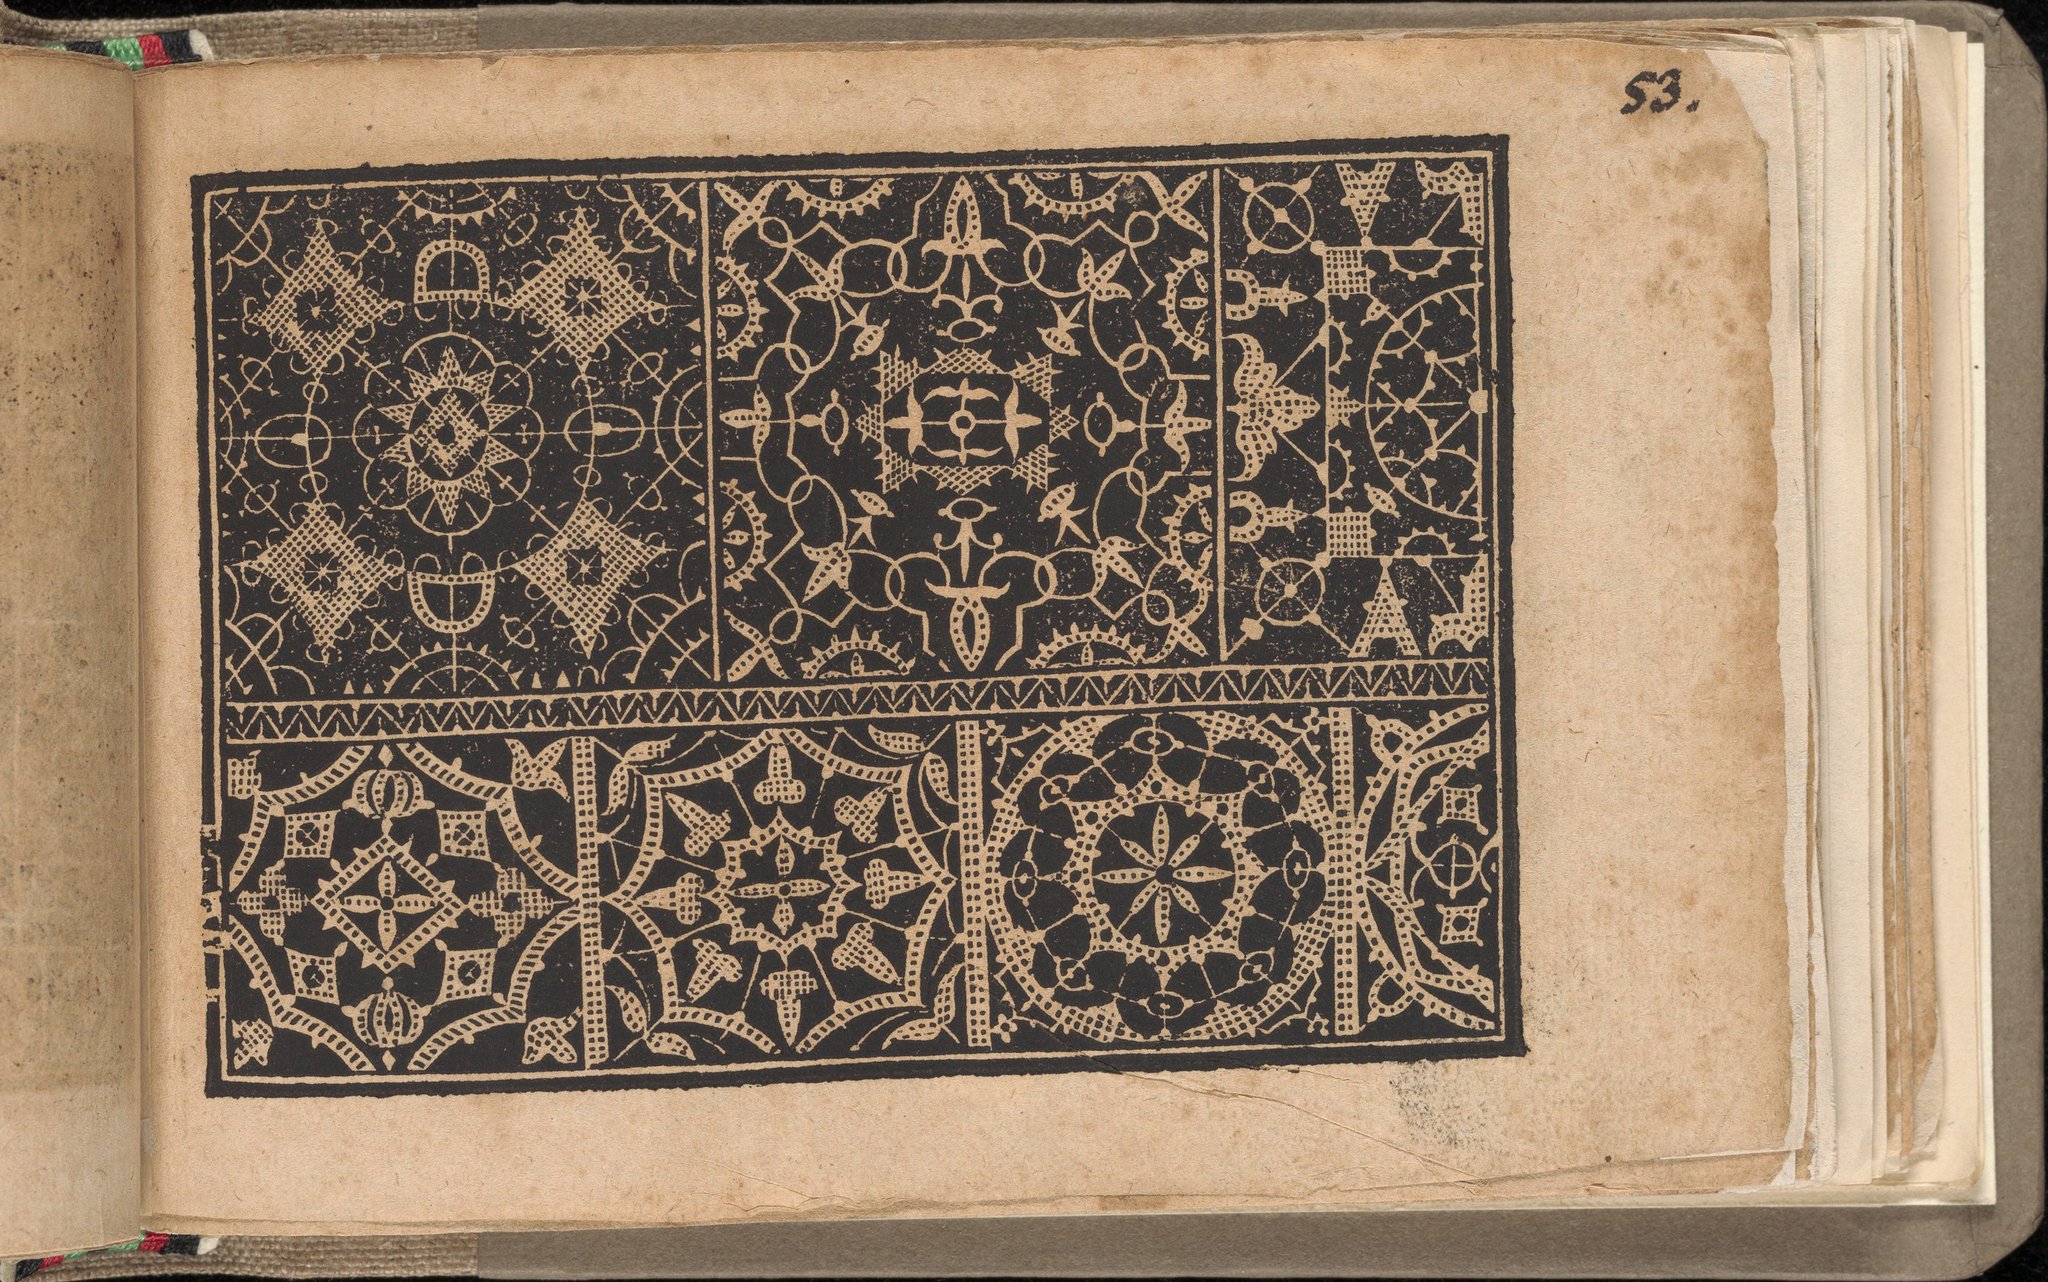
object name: book print ornament architecture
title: Schön newes Modelbuch (Page 53r)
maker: sigismundus latomus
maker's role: publisher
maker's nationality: german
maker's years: 1599-1632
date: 1608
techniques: woodcut